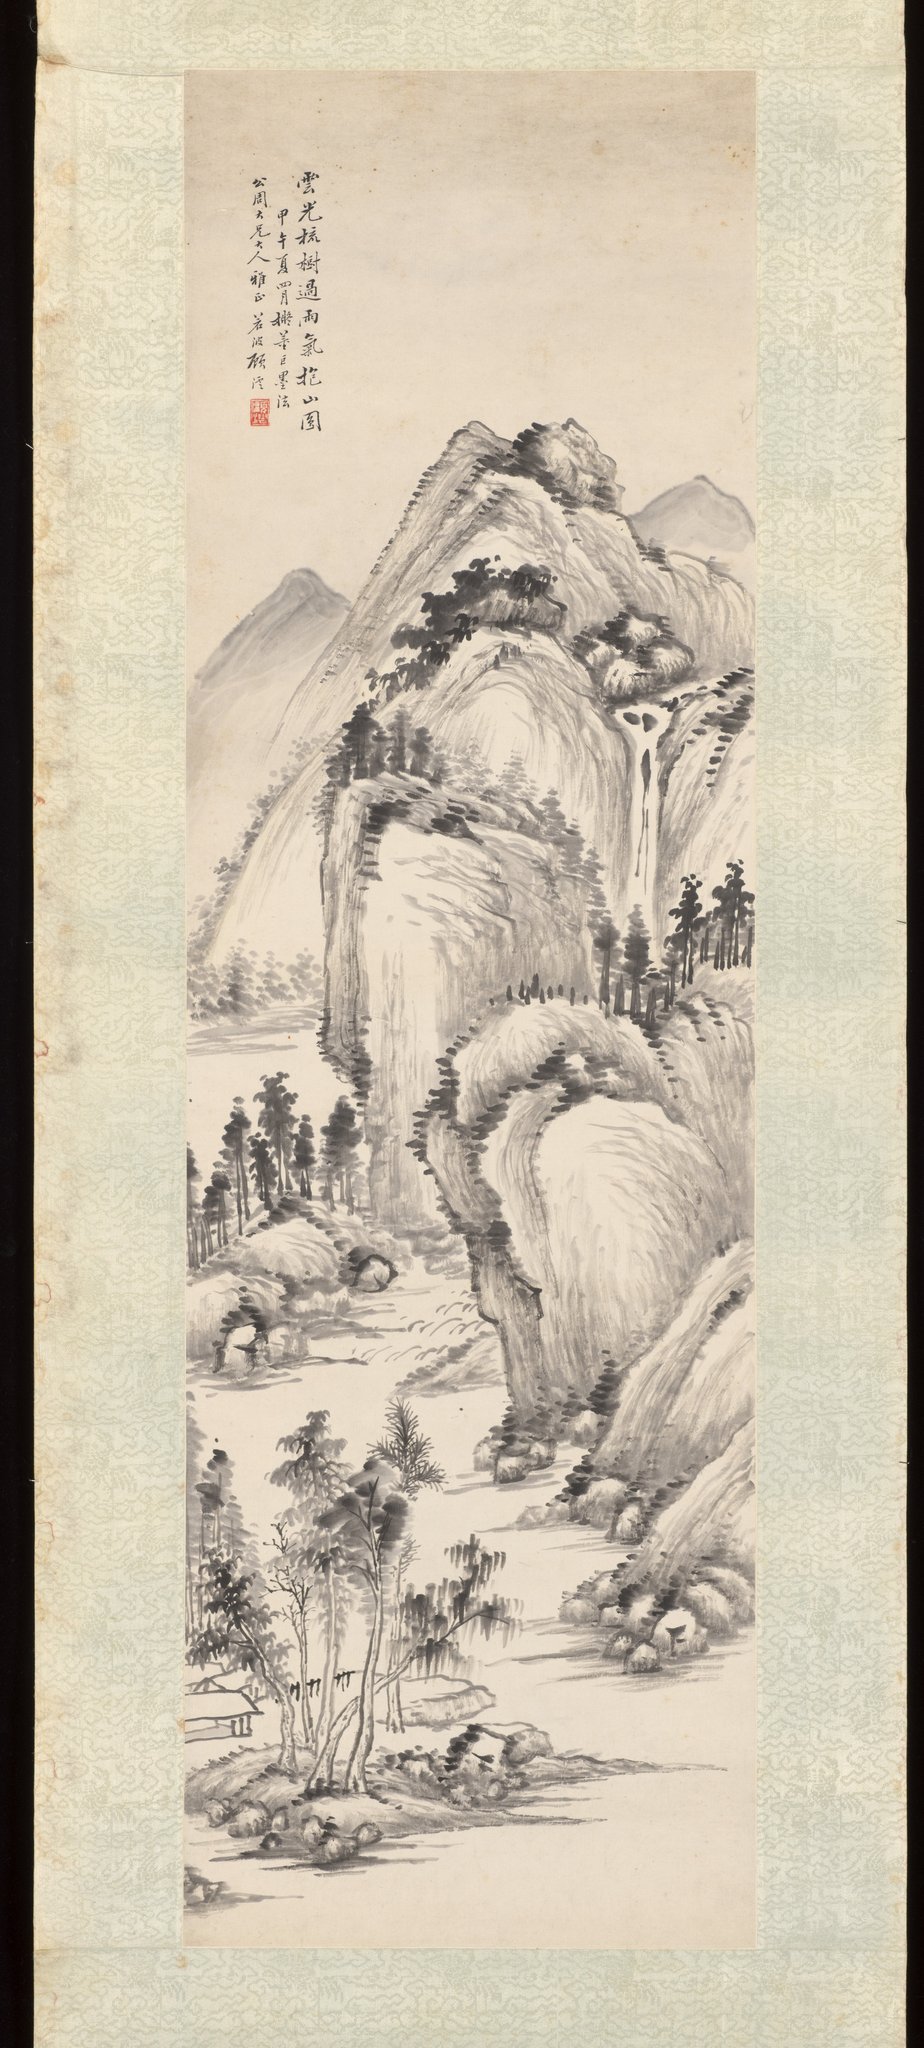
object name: hanging scroll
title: Landscape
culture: chinese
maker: gu yun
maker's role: artist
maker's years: 1835-1896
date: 1894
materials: ink, paper